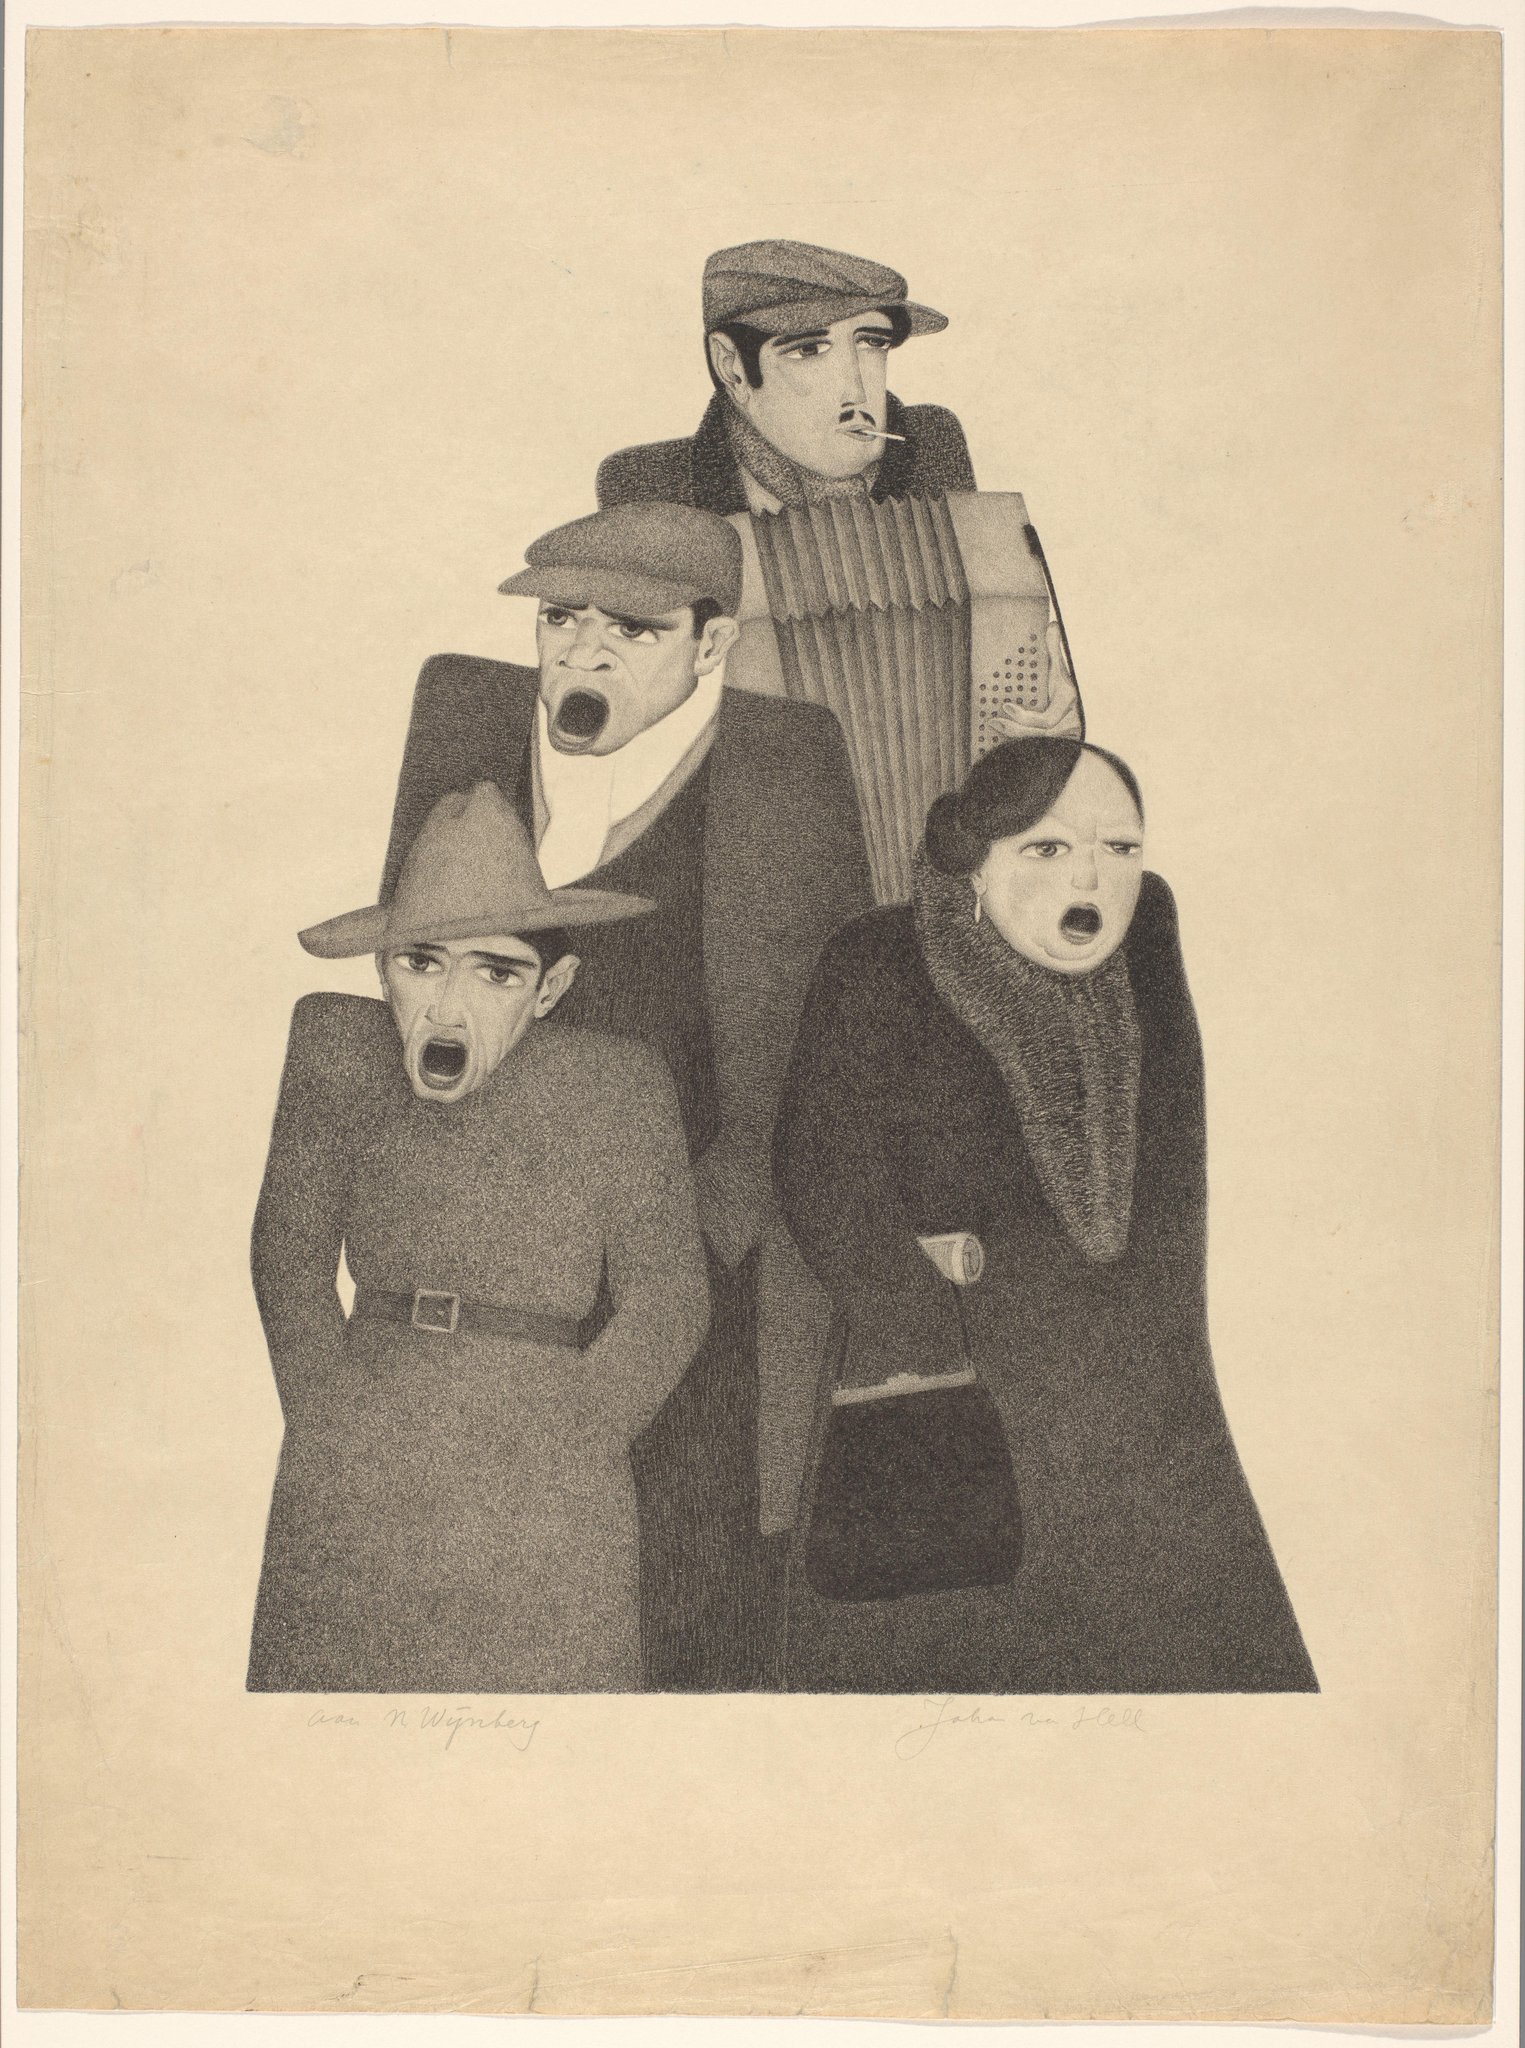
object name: print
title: Straatmuzikanten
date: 1899-1952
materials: paper, ink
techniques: lithograph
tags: vocal popular music - cc - out of doors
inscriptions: dedication: ‘Aan N. Wijnberg’, signature: ‘Johan van Hell’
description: Twee zingende mannen, een zingende vrouw en een man met een accordeon.